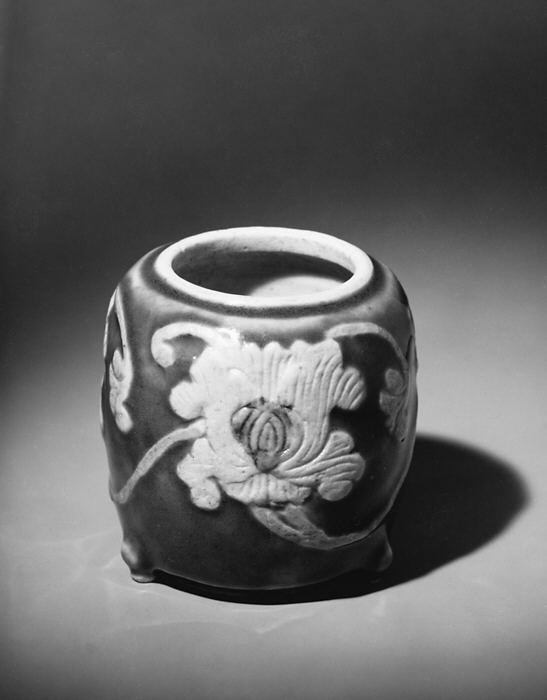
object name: incense burner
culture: japanese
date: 1615-1868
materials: cobalt, glaze, porcelain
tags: flowers